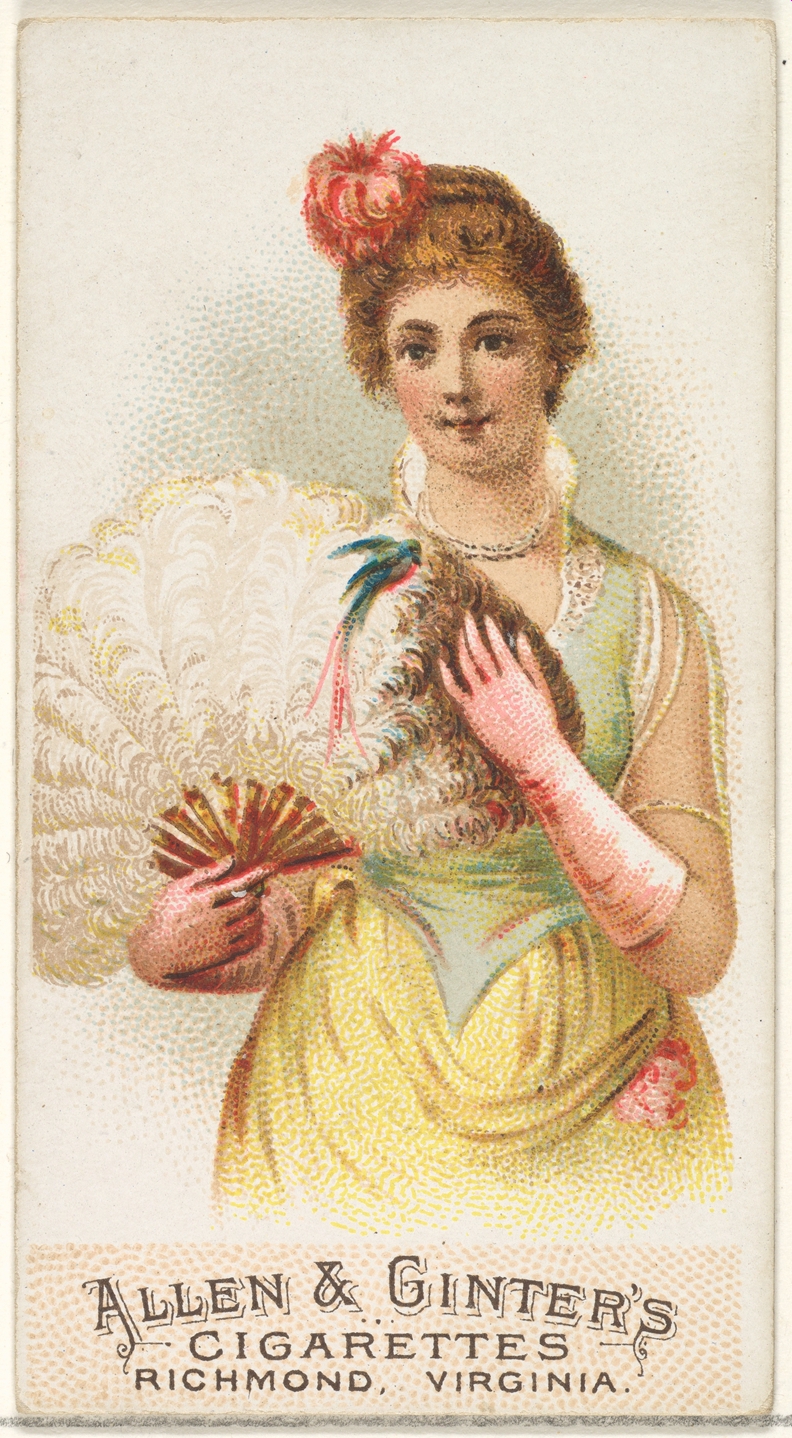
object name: print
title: Plate 9, from the Fans of the Period series (N7) for Allen & Ginter Cigarettes Brands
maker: allen & ginter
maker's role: publisher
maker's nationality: american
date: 1889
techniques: color lithograph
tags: fans,women